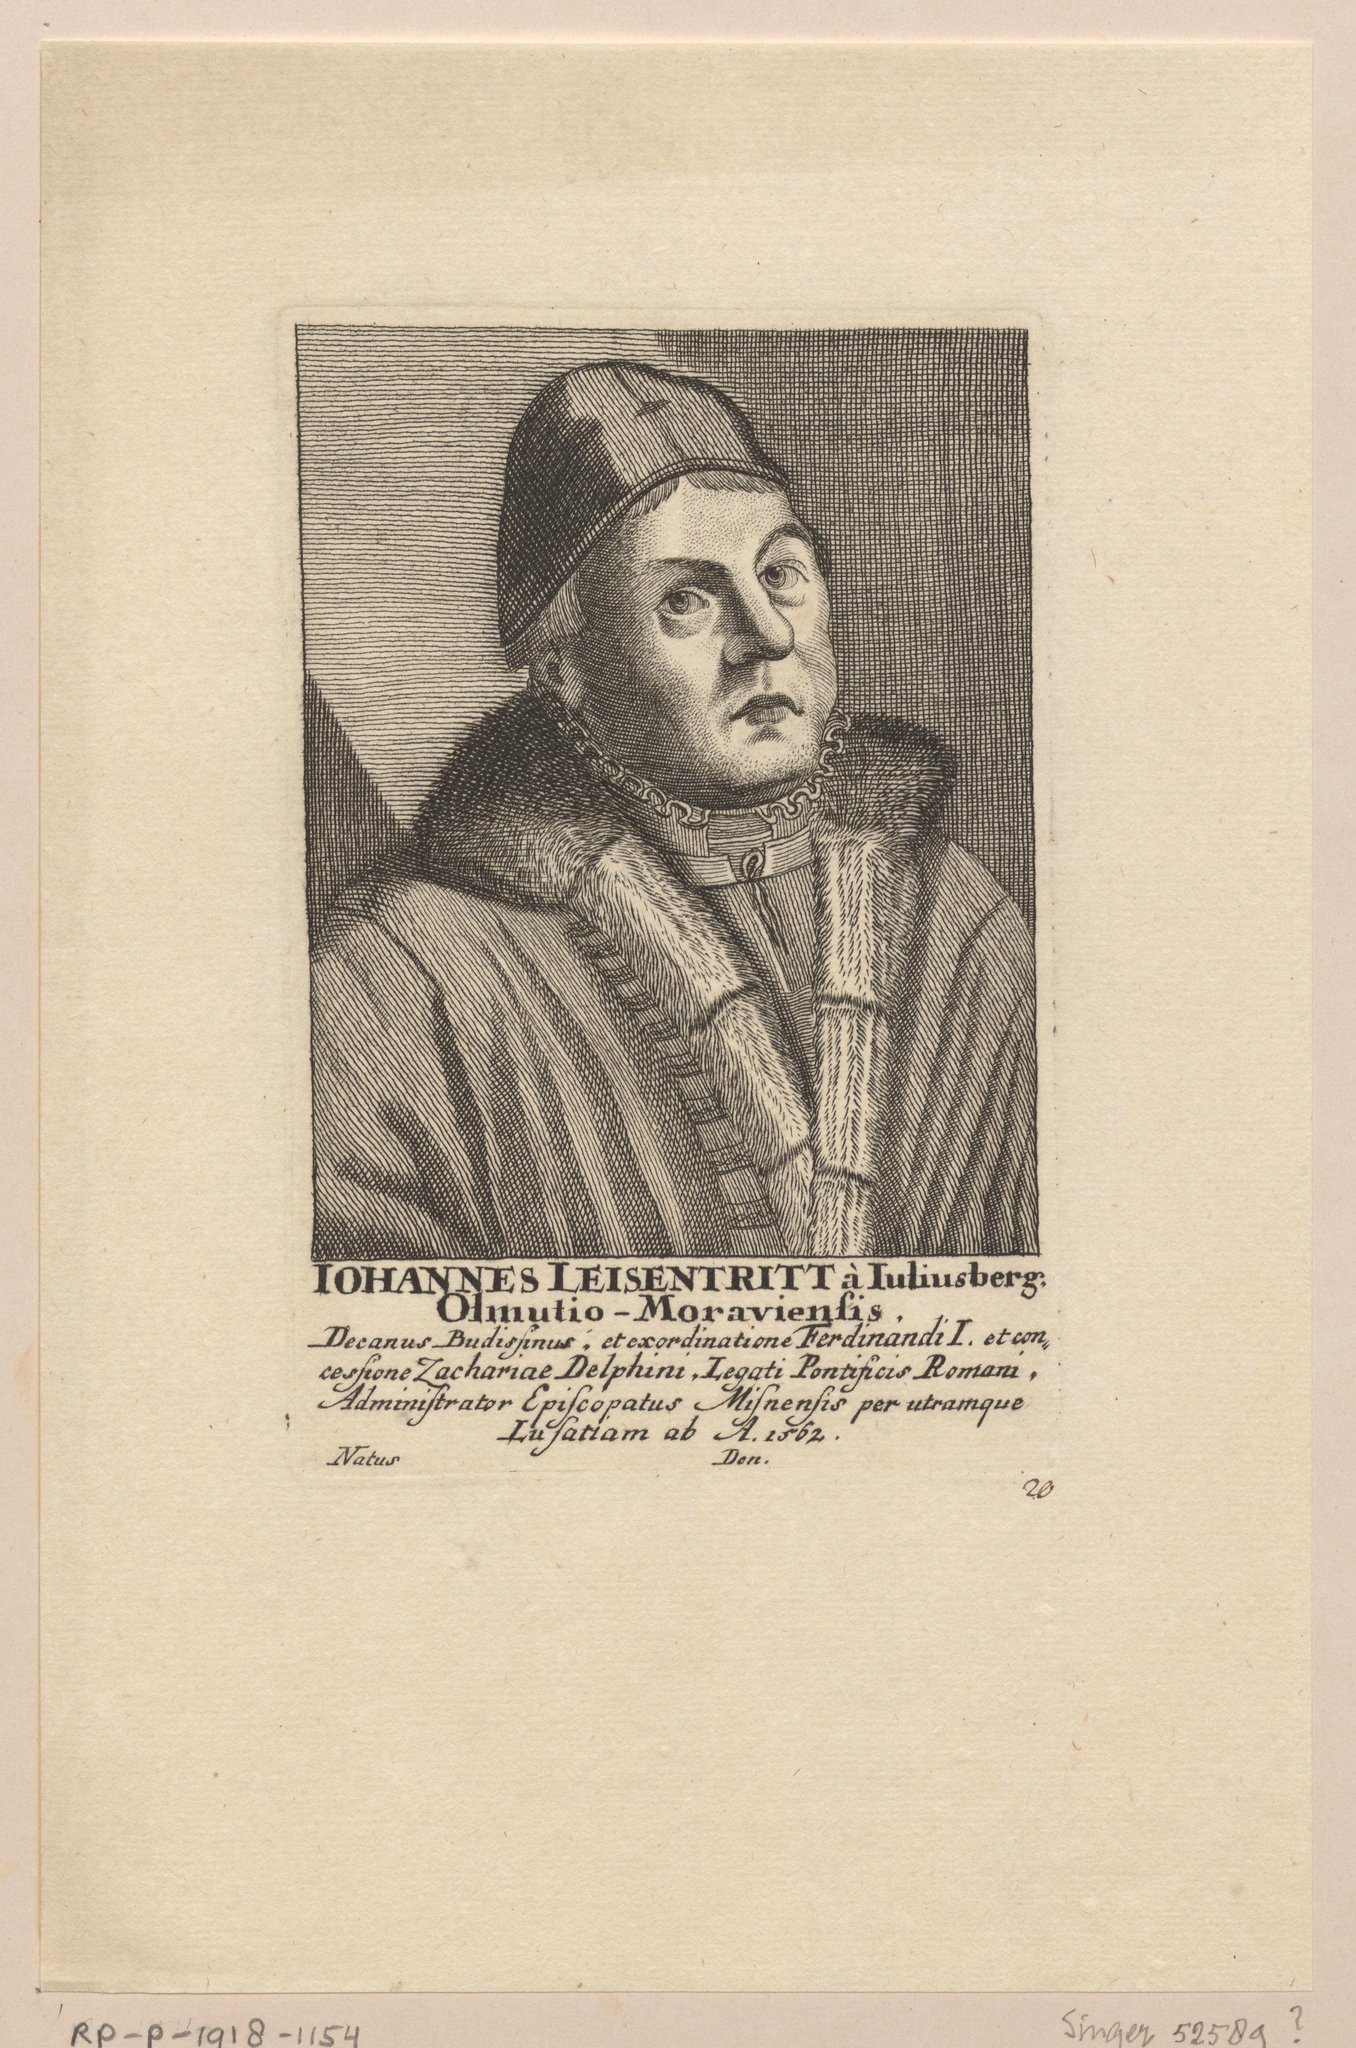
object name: book illustration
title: Portret van Johann Leisentritt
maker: Anonymous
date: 1725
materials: paper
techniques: engraving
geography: germany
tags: priest (roman catholic), historical persons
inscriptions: collector's mark: Lugt 2233, number: ‘20’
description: Prent waarschijnlijk uit: Roth-Scholtz, Friedrich. Icones virorum omnium ordinum eruditione omnique item genere (...). Neurenberg: erven Johann Daniel Tauber, 1725.